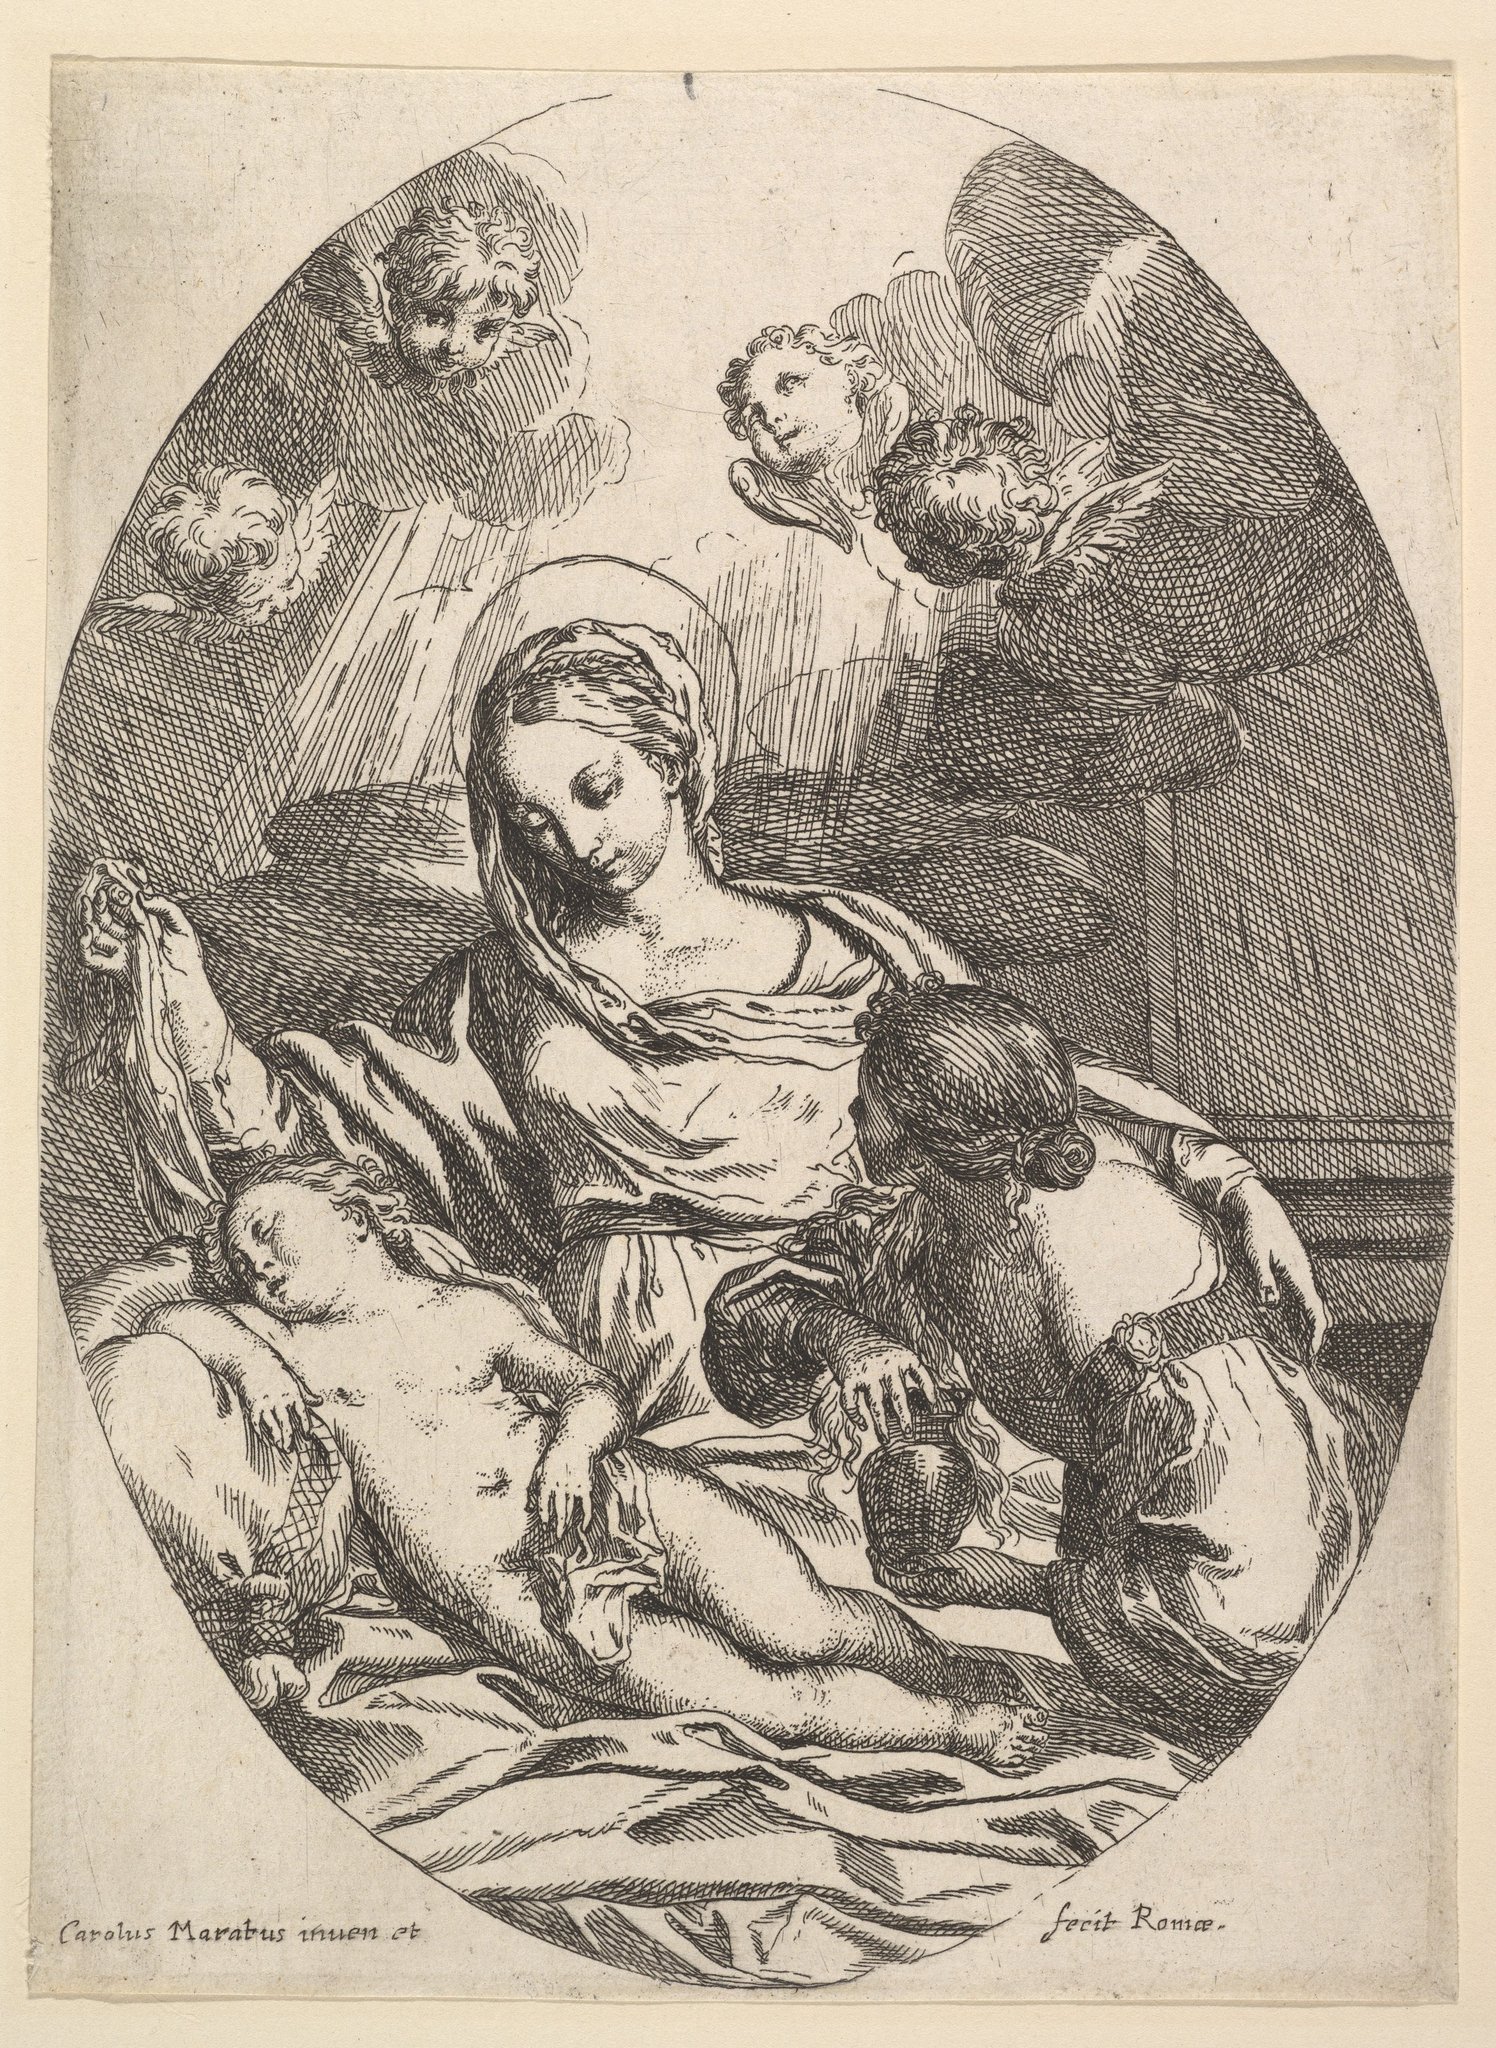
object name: print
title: Virgin and Child with St. Mary Magdalen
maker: carlo maratti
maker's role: artist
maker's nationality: italian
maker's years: 1625-1713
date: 1601-1700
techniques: etching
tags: angels,madonna and child,mary magdalene